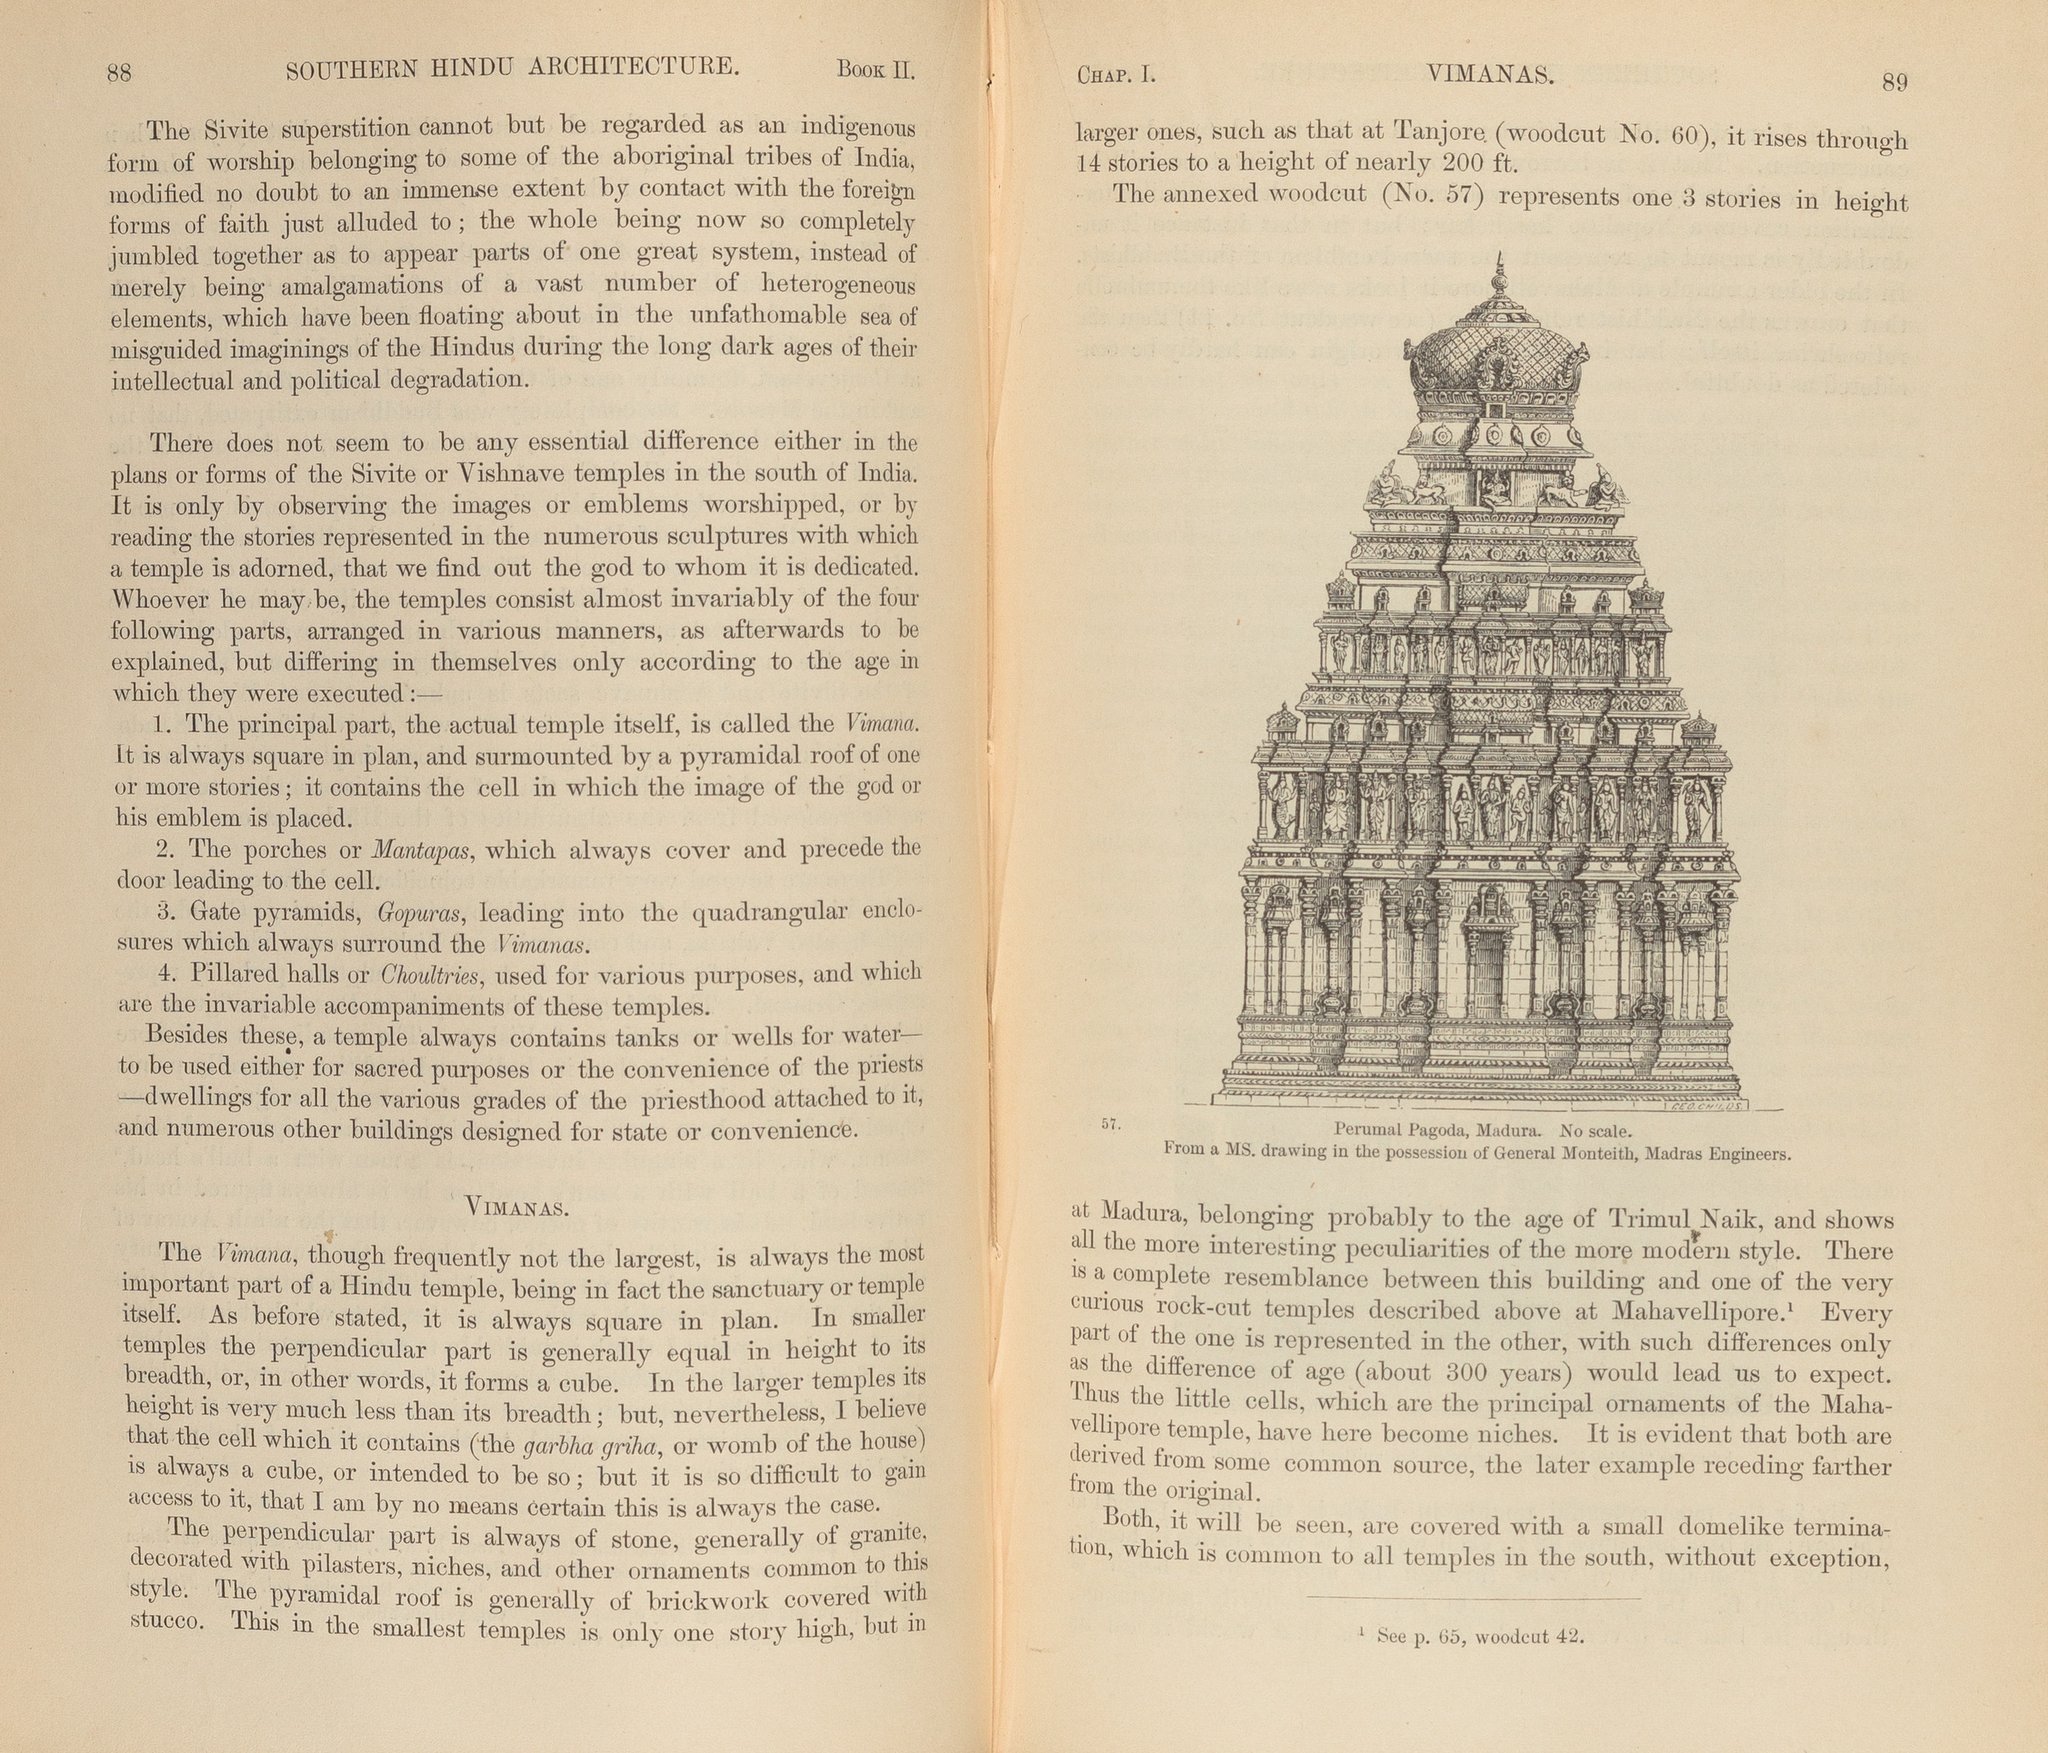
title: The illustrated handbook of architecture : being a concise and popular account of the different styles of architecture prevailing in all ages and all countries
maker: james fergusson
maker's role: author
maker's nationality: british, scottish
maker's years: 1808-1886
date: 1855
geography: england